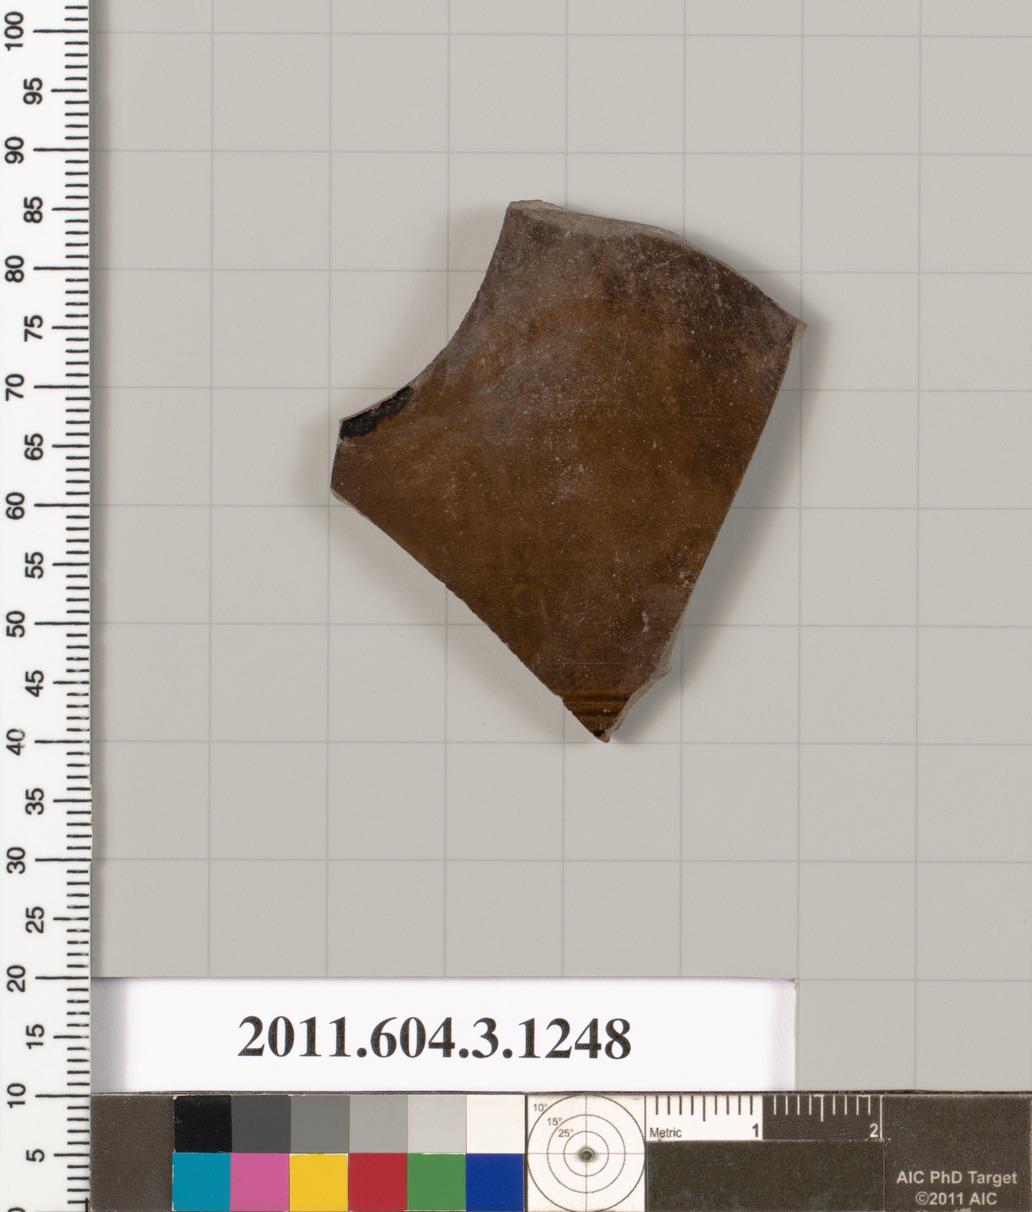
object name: kyathos fragment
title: Terracotta fragment of a kyathos (cup-shaped ladle)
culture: greek, attic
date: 534-468 BCE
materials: terracotta